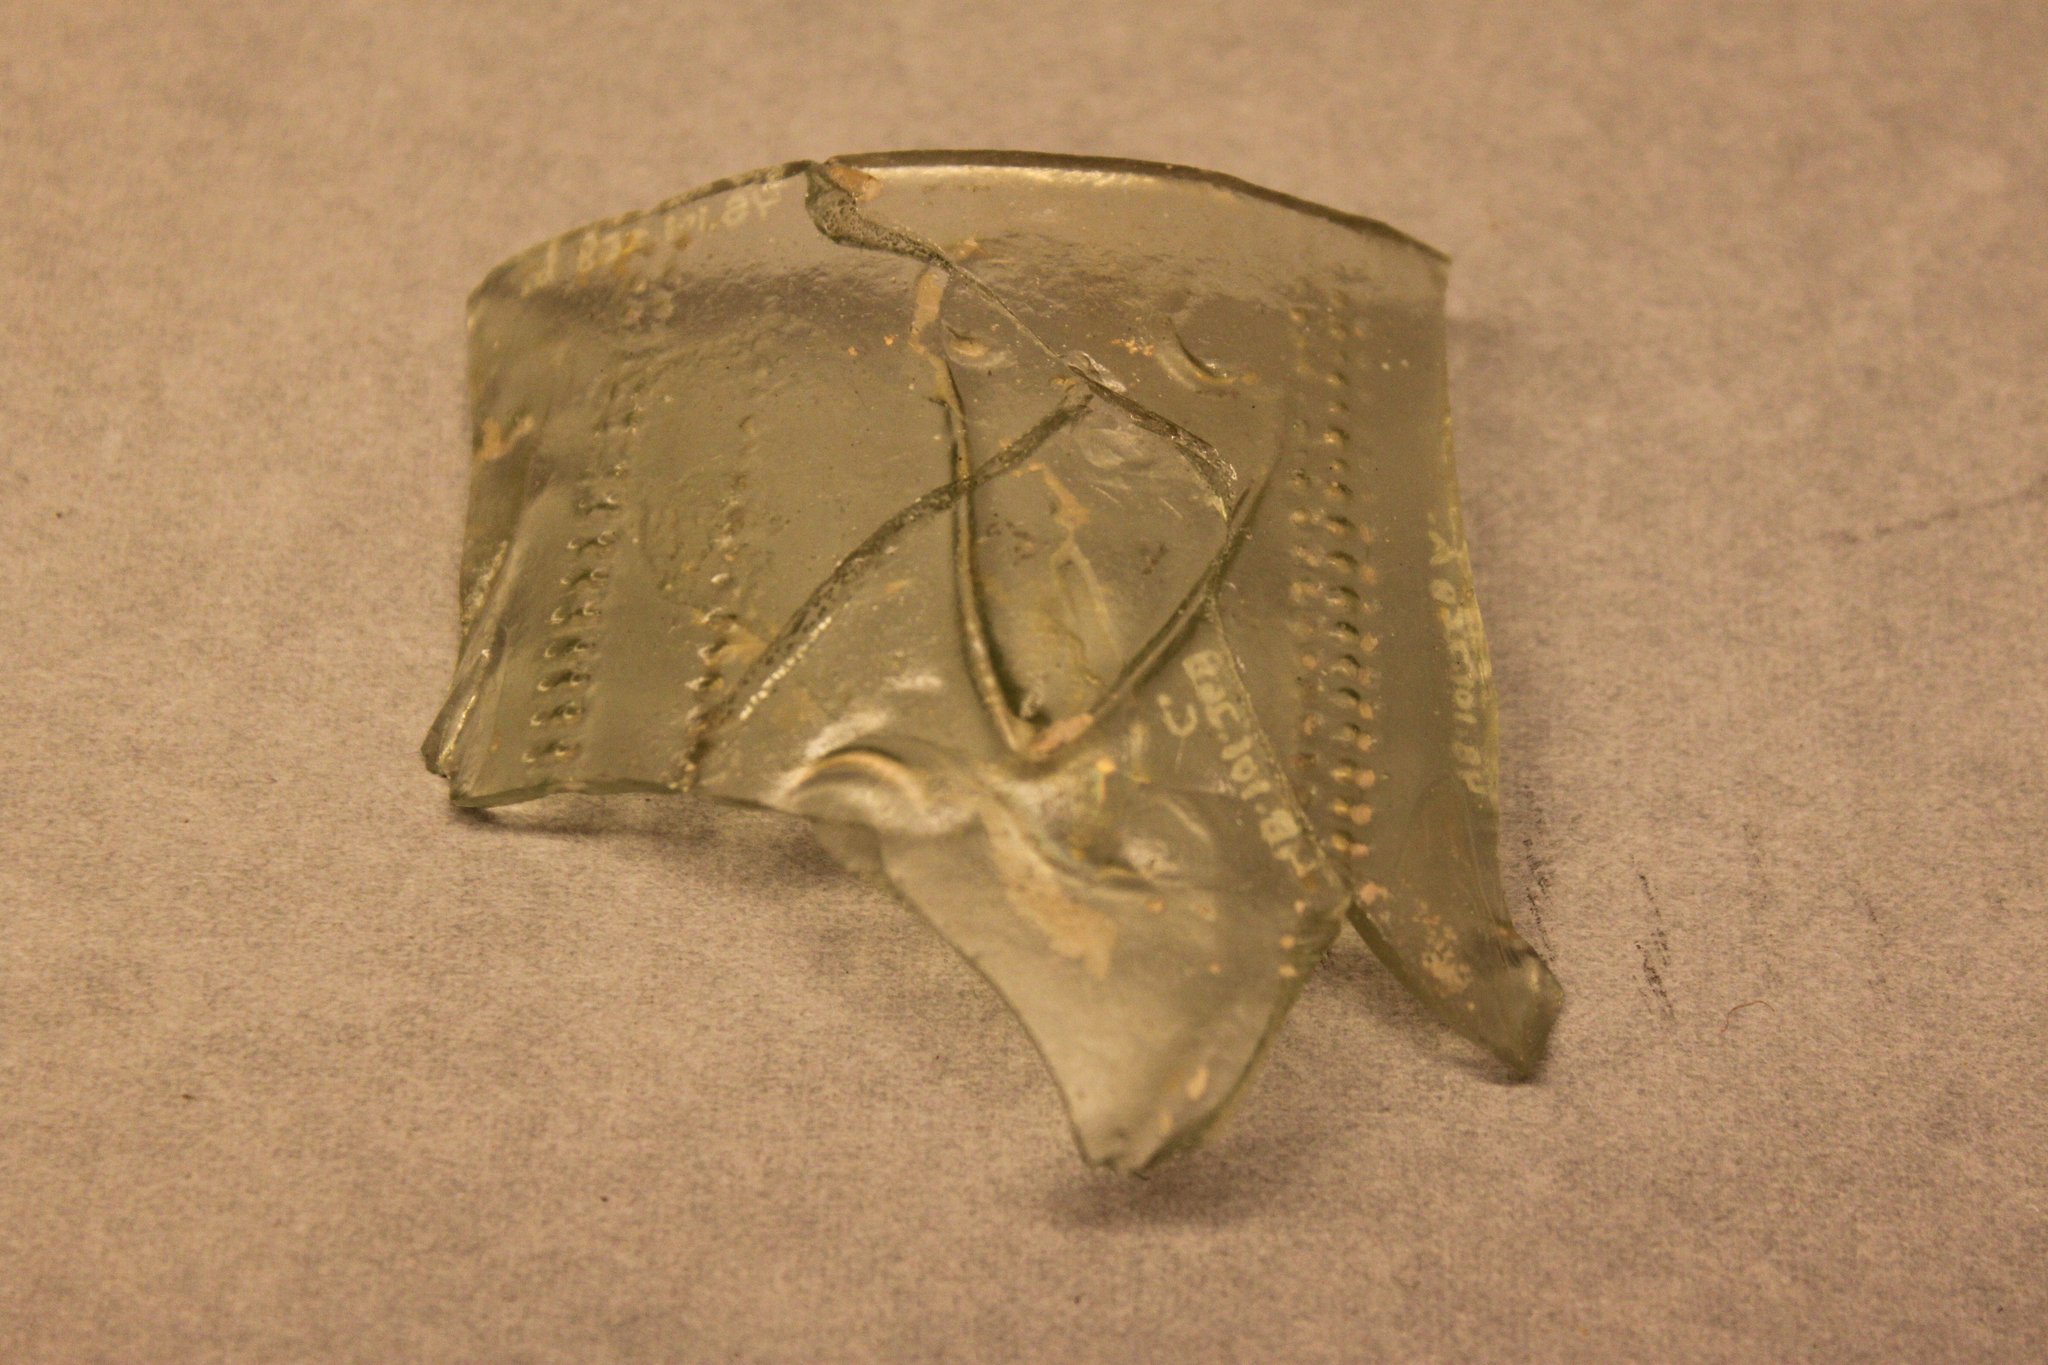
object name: fragment of a beaker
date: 801-1000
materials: glass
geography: iran